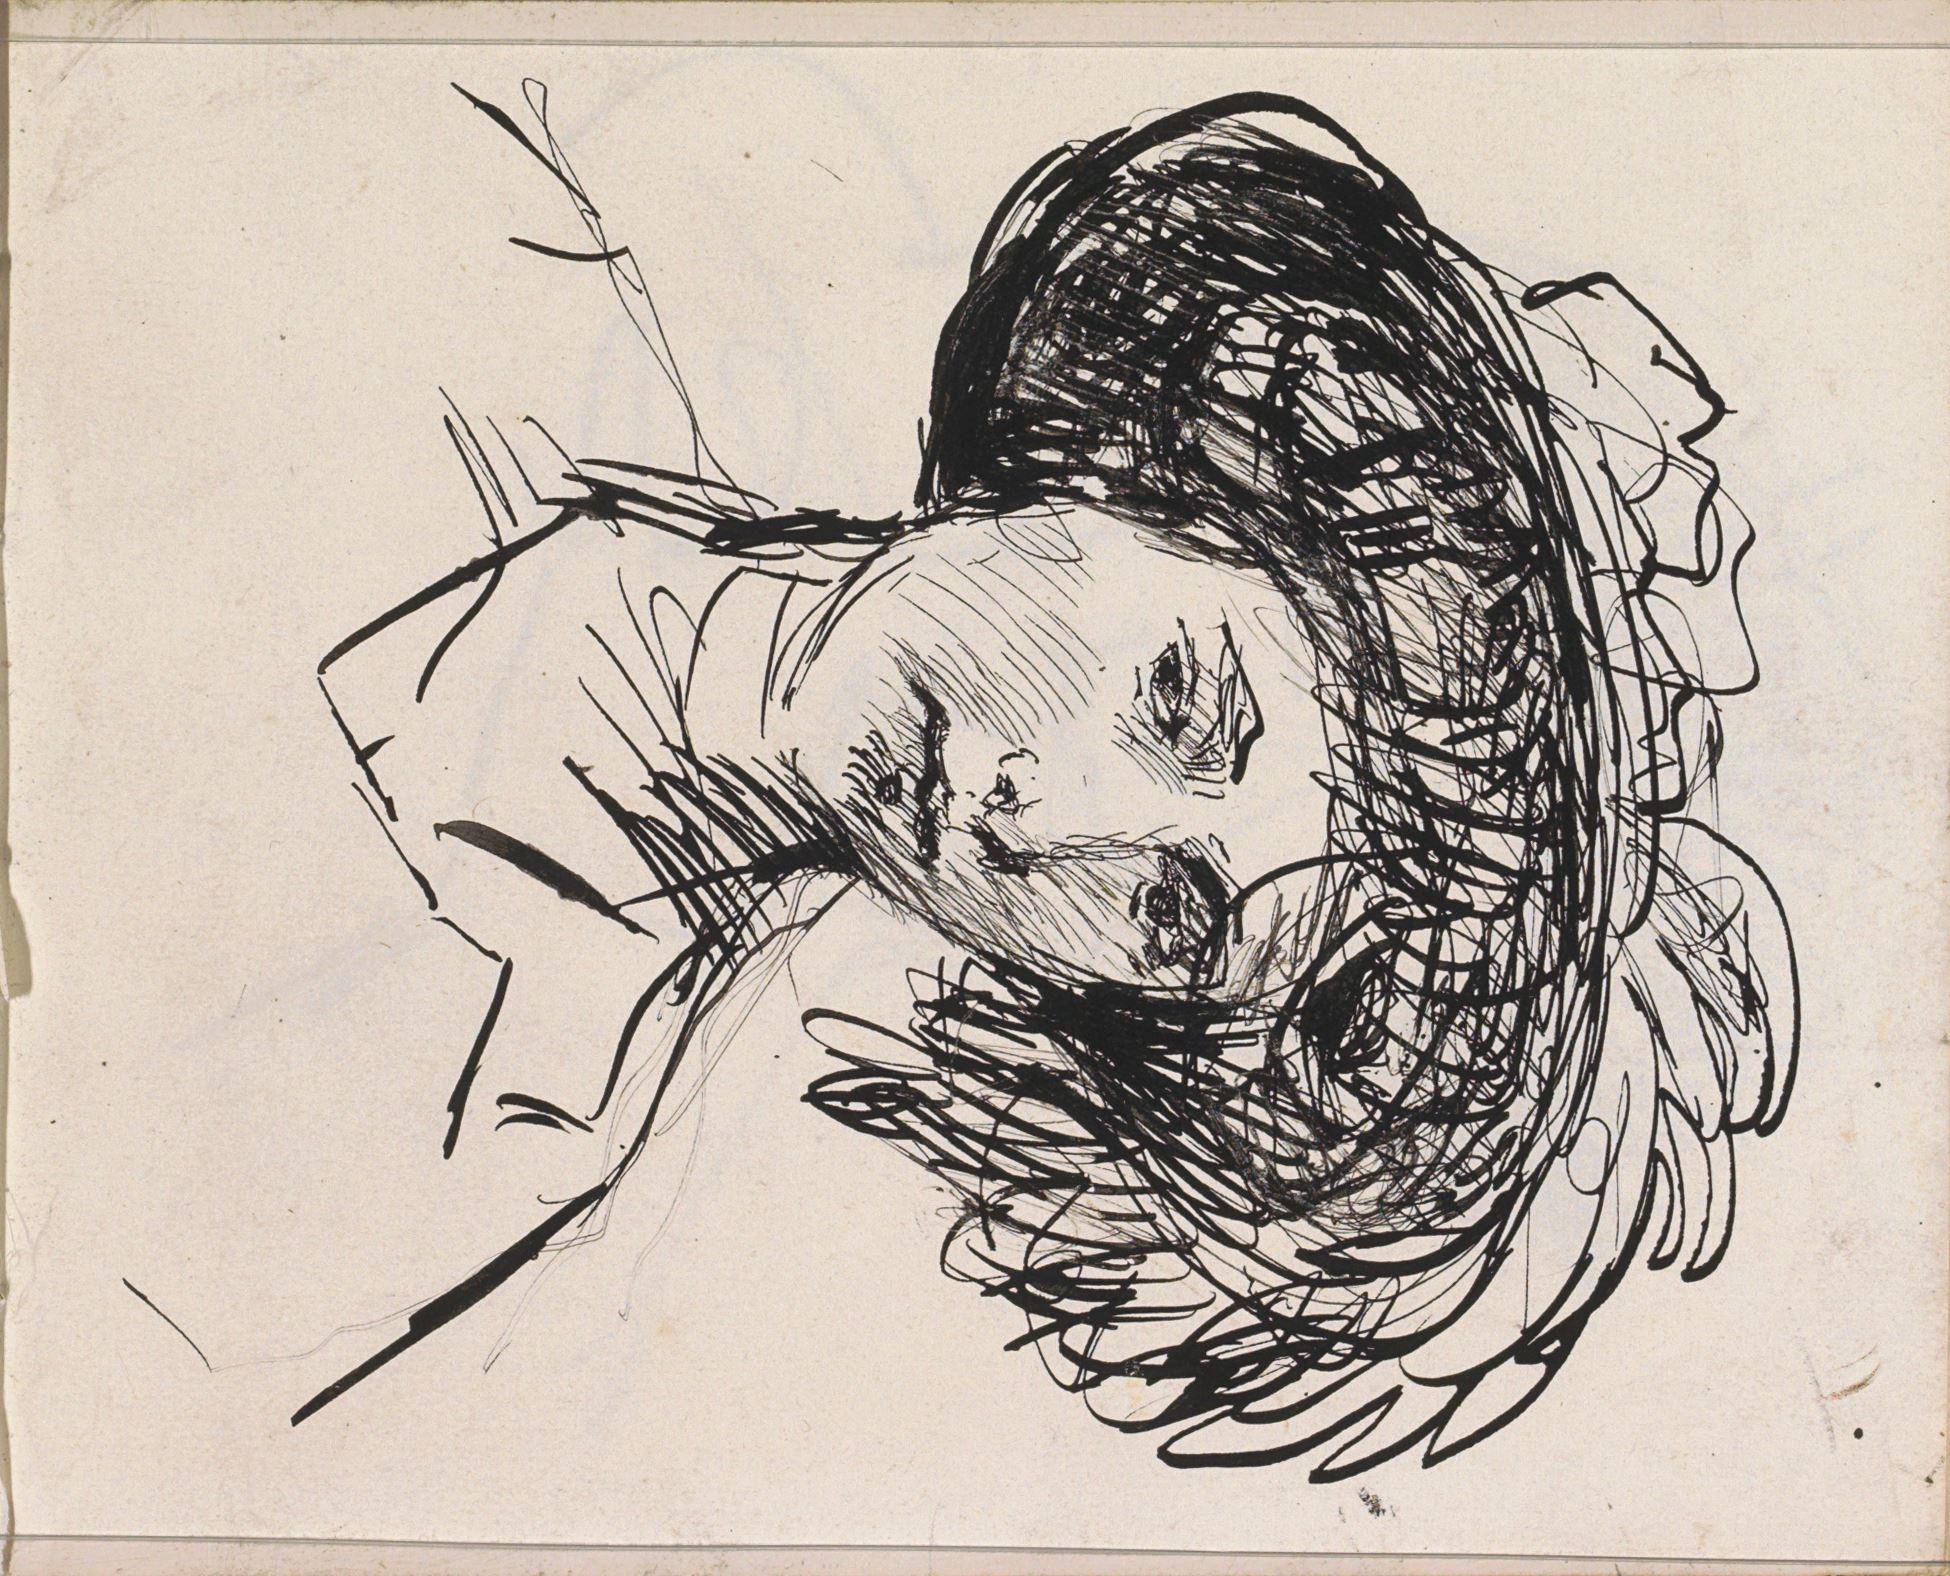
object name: sketchbook leaf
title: Vrouwenhoofd met hoed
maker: isaac israels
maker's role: draughtsman, painter, print maker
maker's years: 1865-1934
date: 1875-1934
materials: ink, paper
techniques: pen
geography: the hague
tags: head-gear: hat (+ women's clothes), head (human) - aa - female human figure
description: Pagina 12 uit schetsboek XLIII met 61 pagina's.